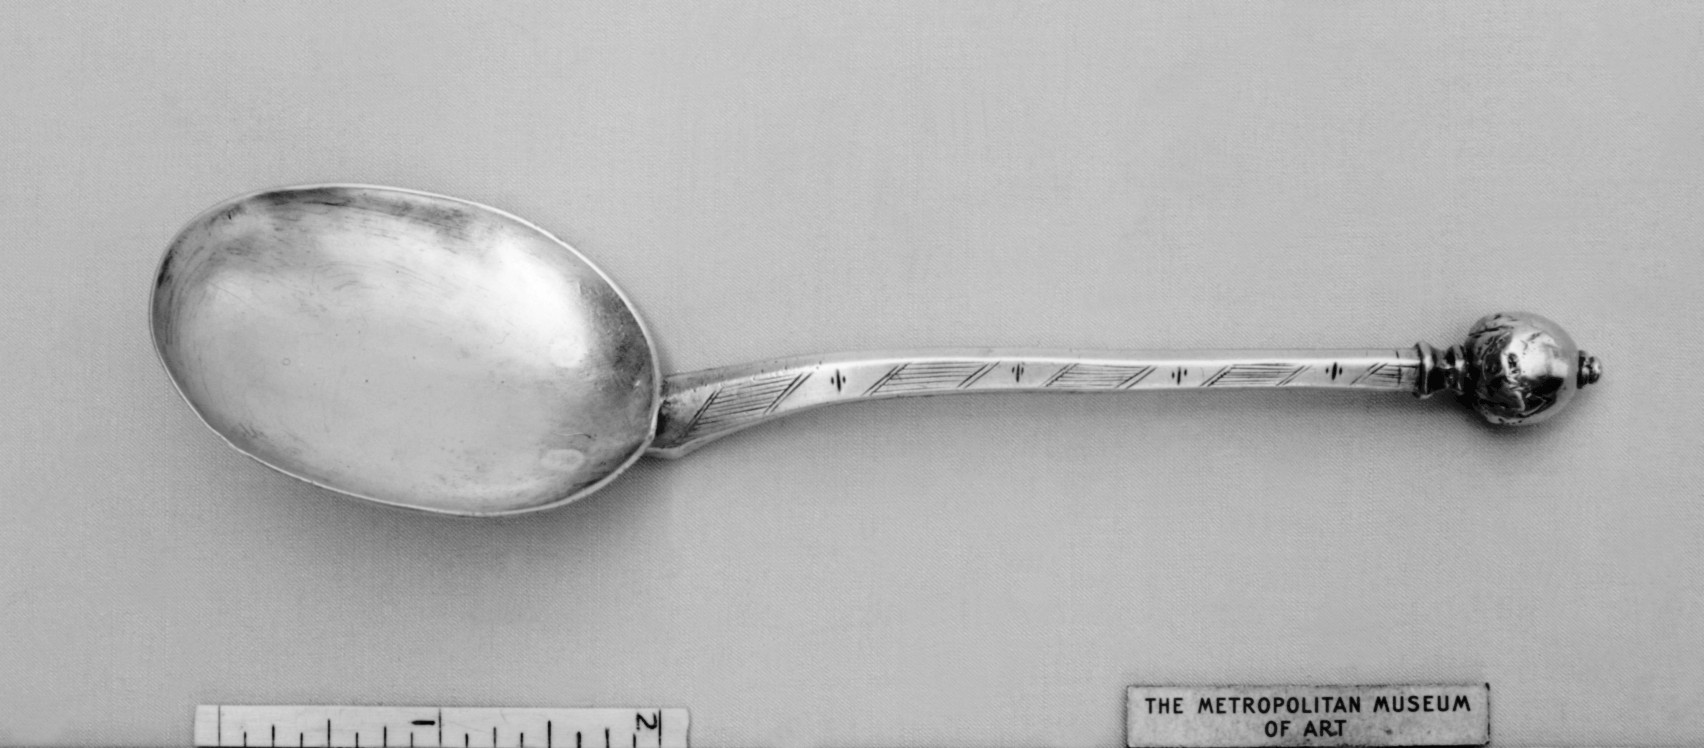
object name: spoon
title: Acorn-top spoon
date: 1601-1650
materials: gilt, silver